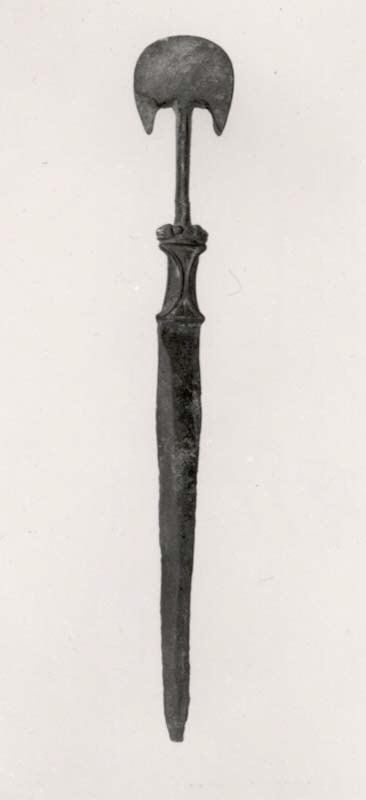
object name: dagger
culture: iranian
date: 1000-801 BCE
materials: bronze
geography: western iran